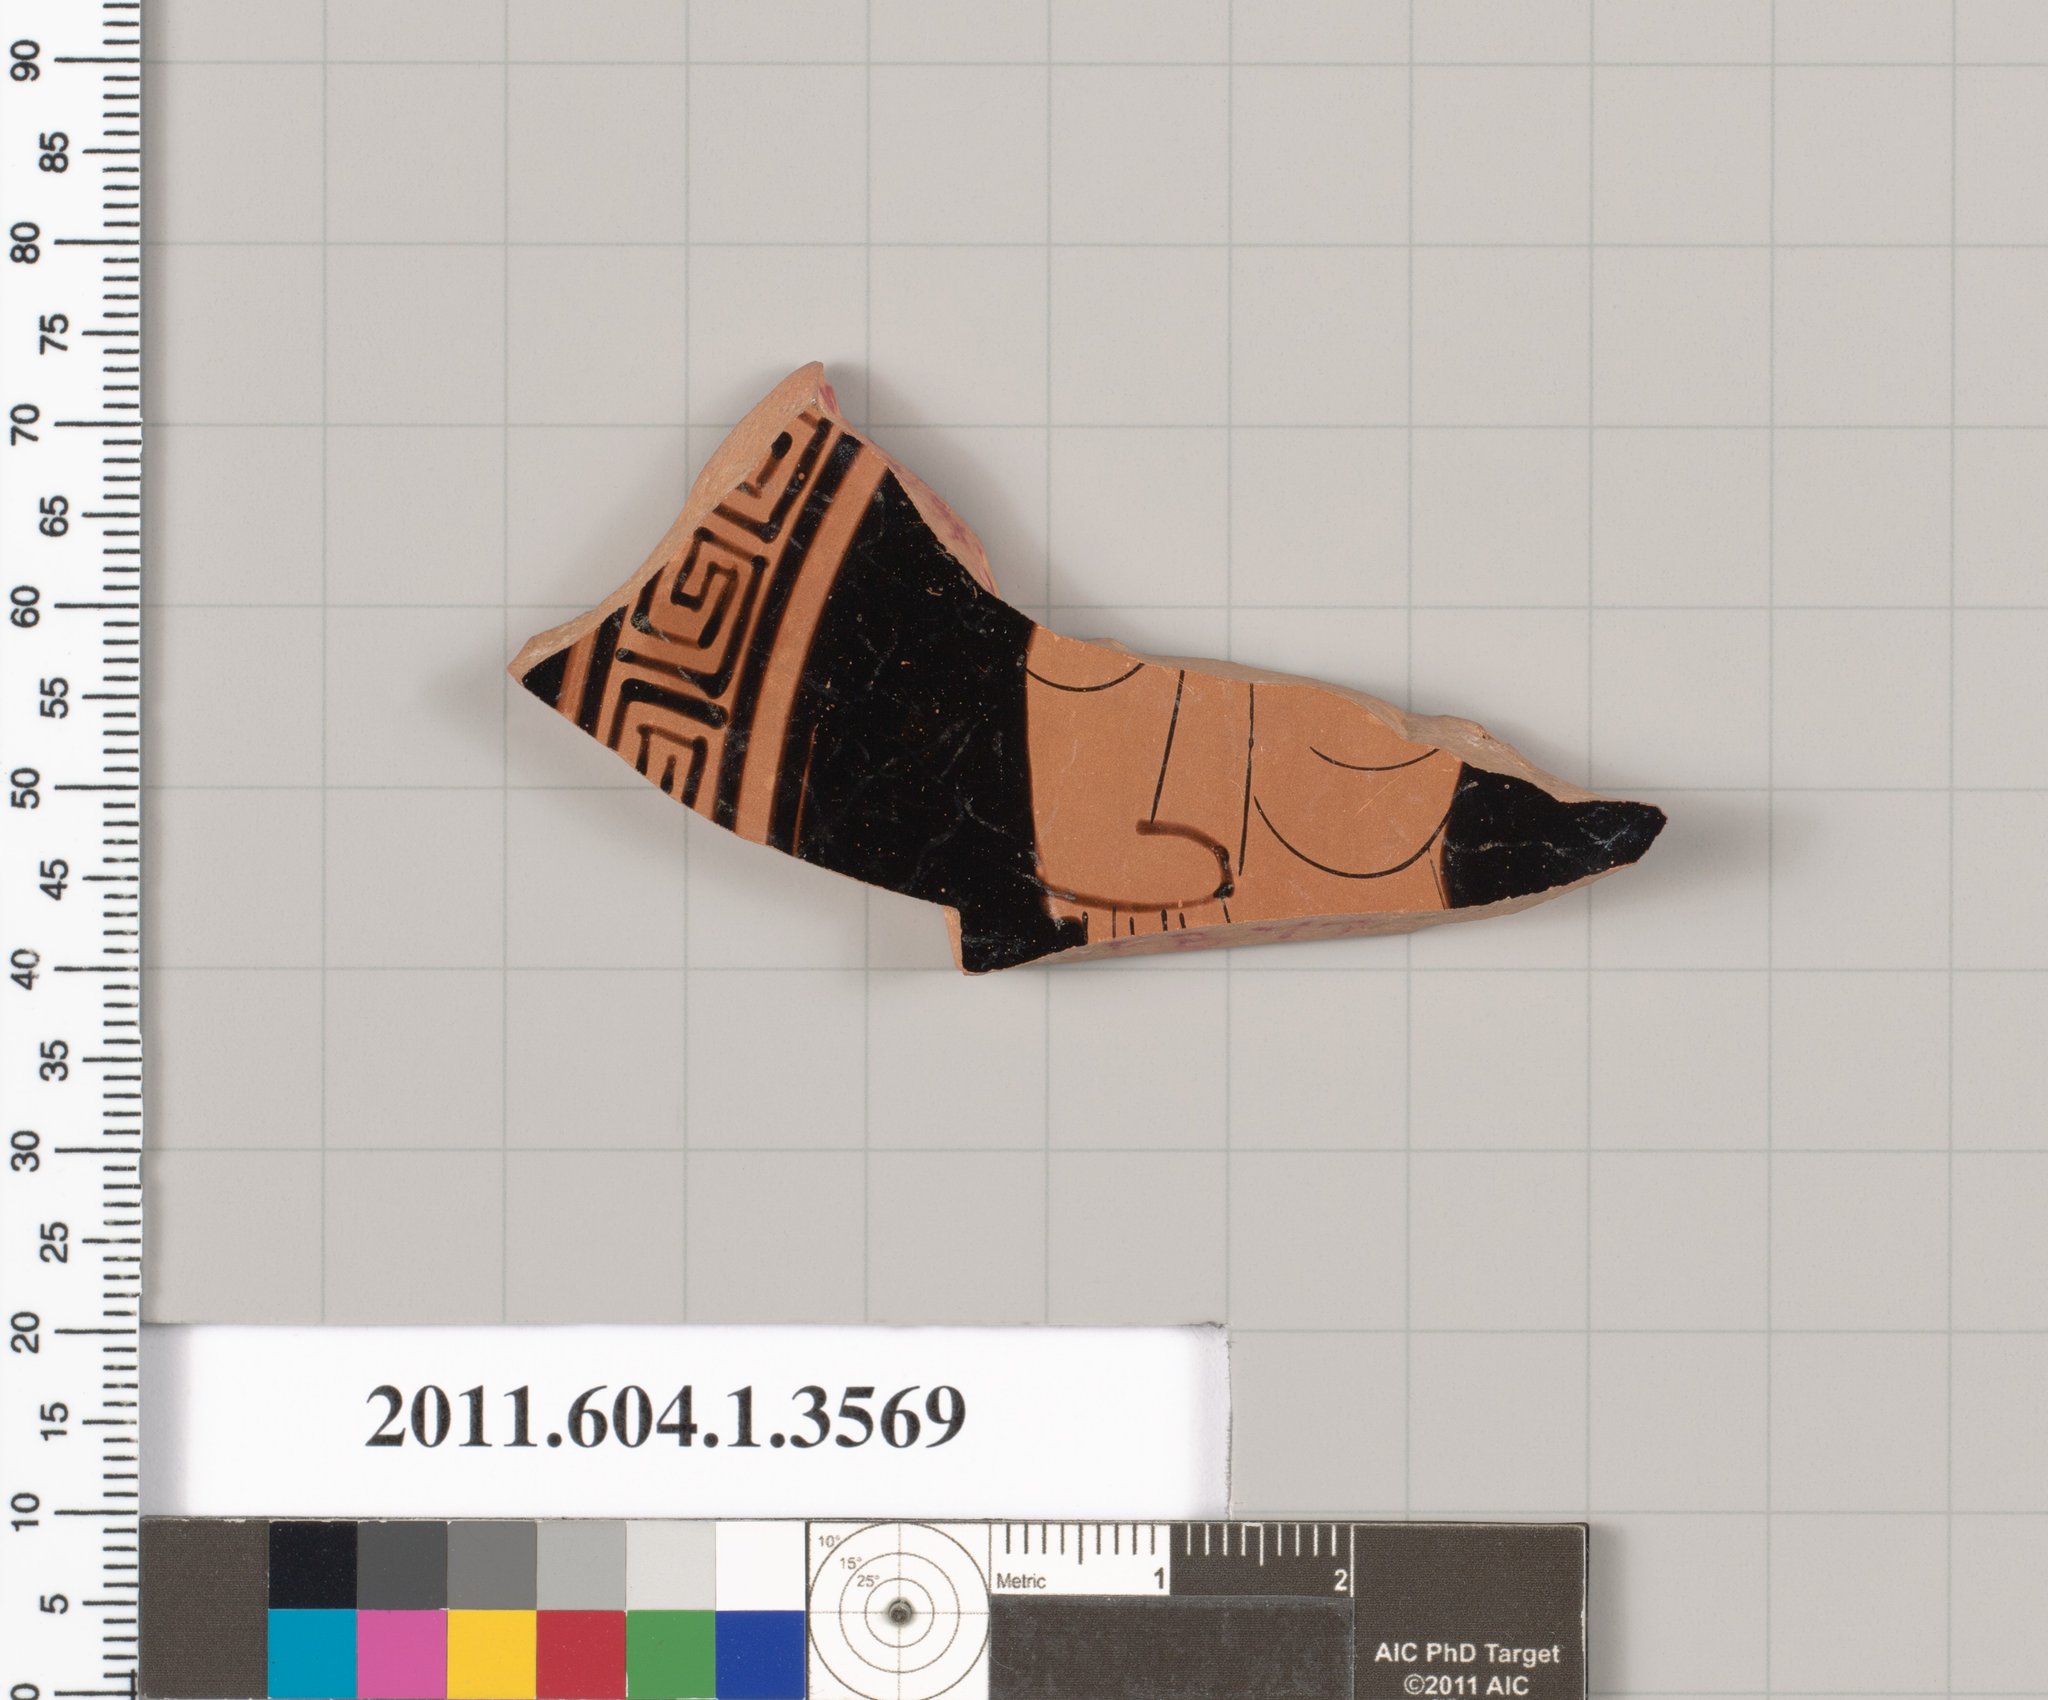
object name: kylix fragment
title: Terracotta fragment of a kylix (drinking cup)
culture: greek, attic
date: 475-451 BCE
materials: terracotta